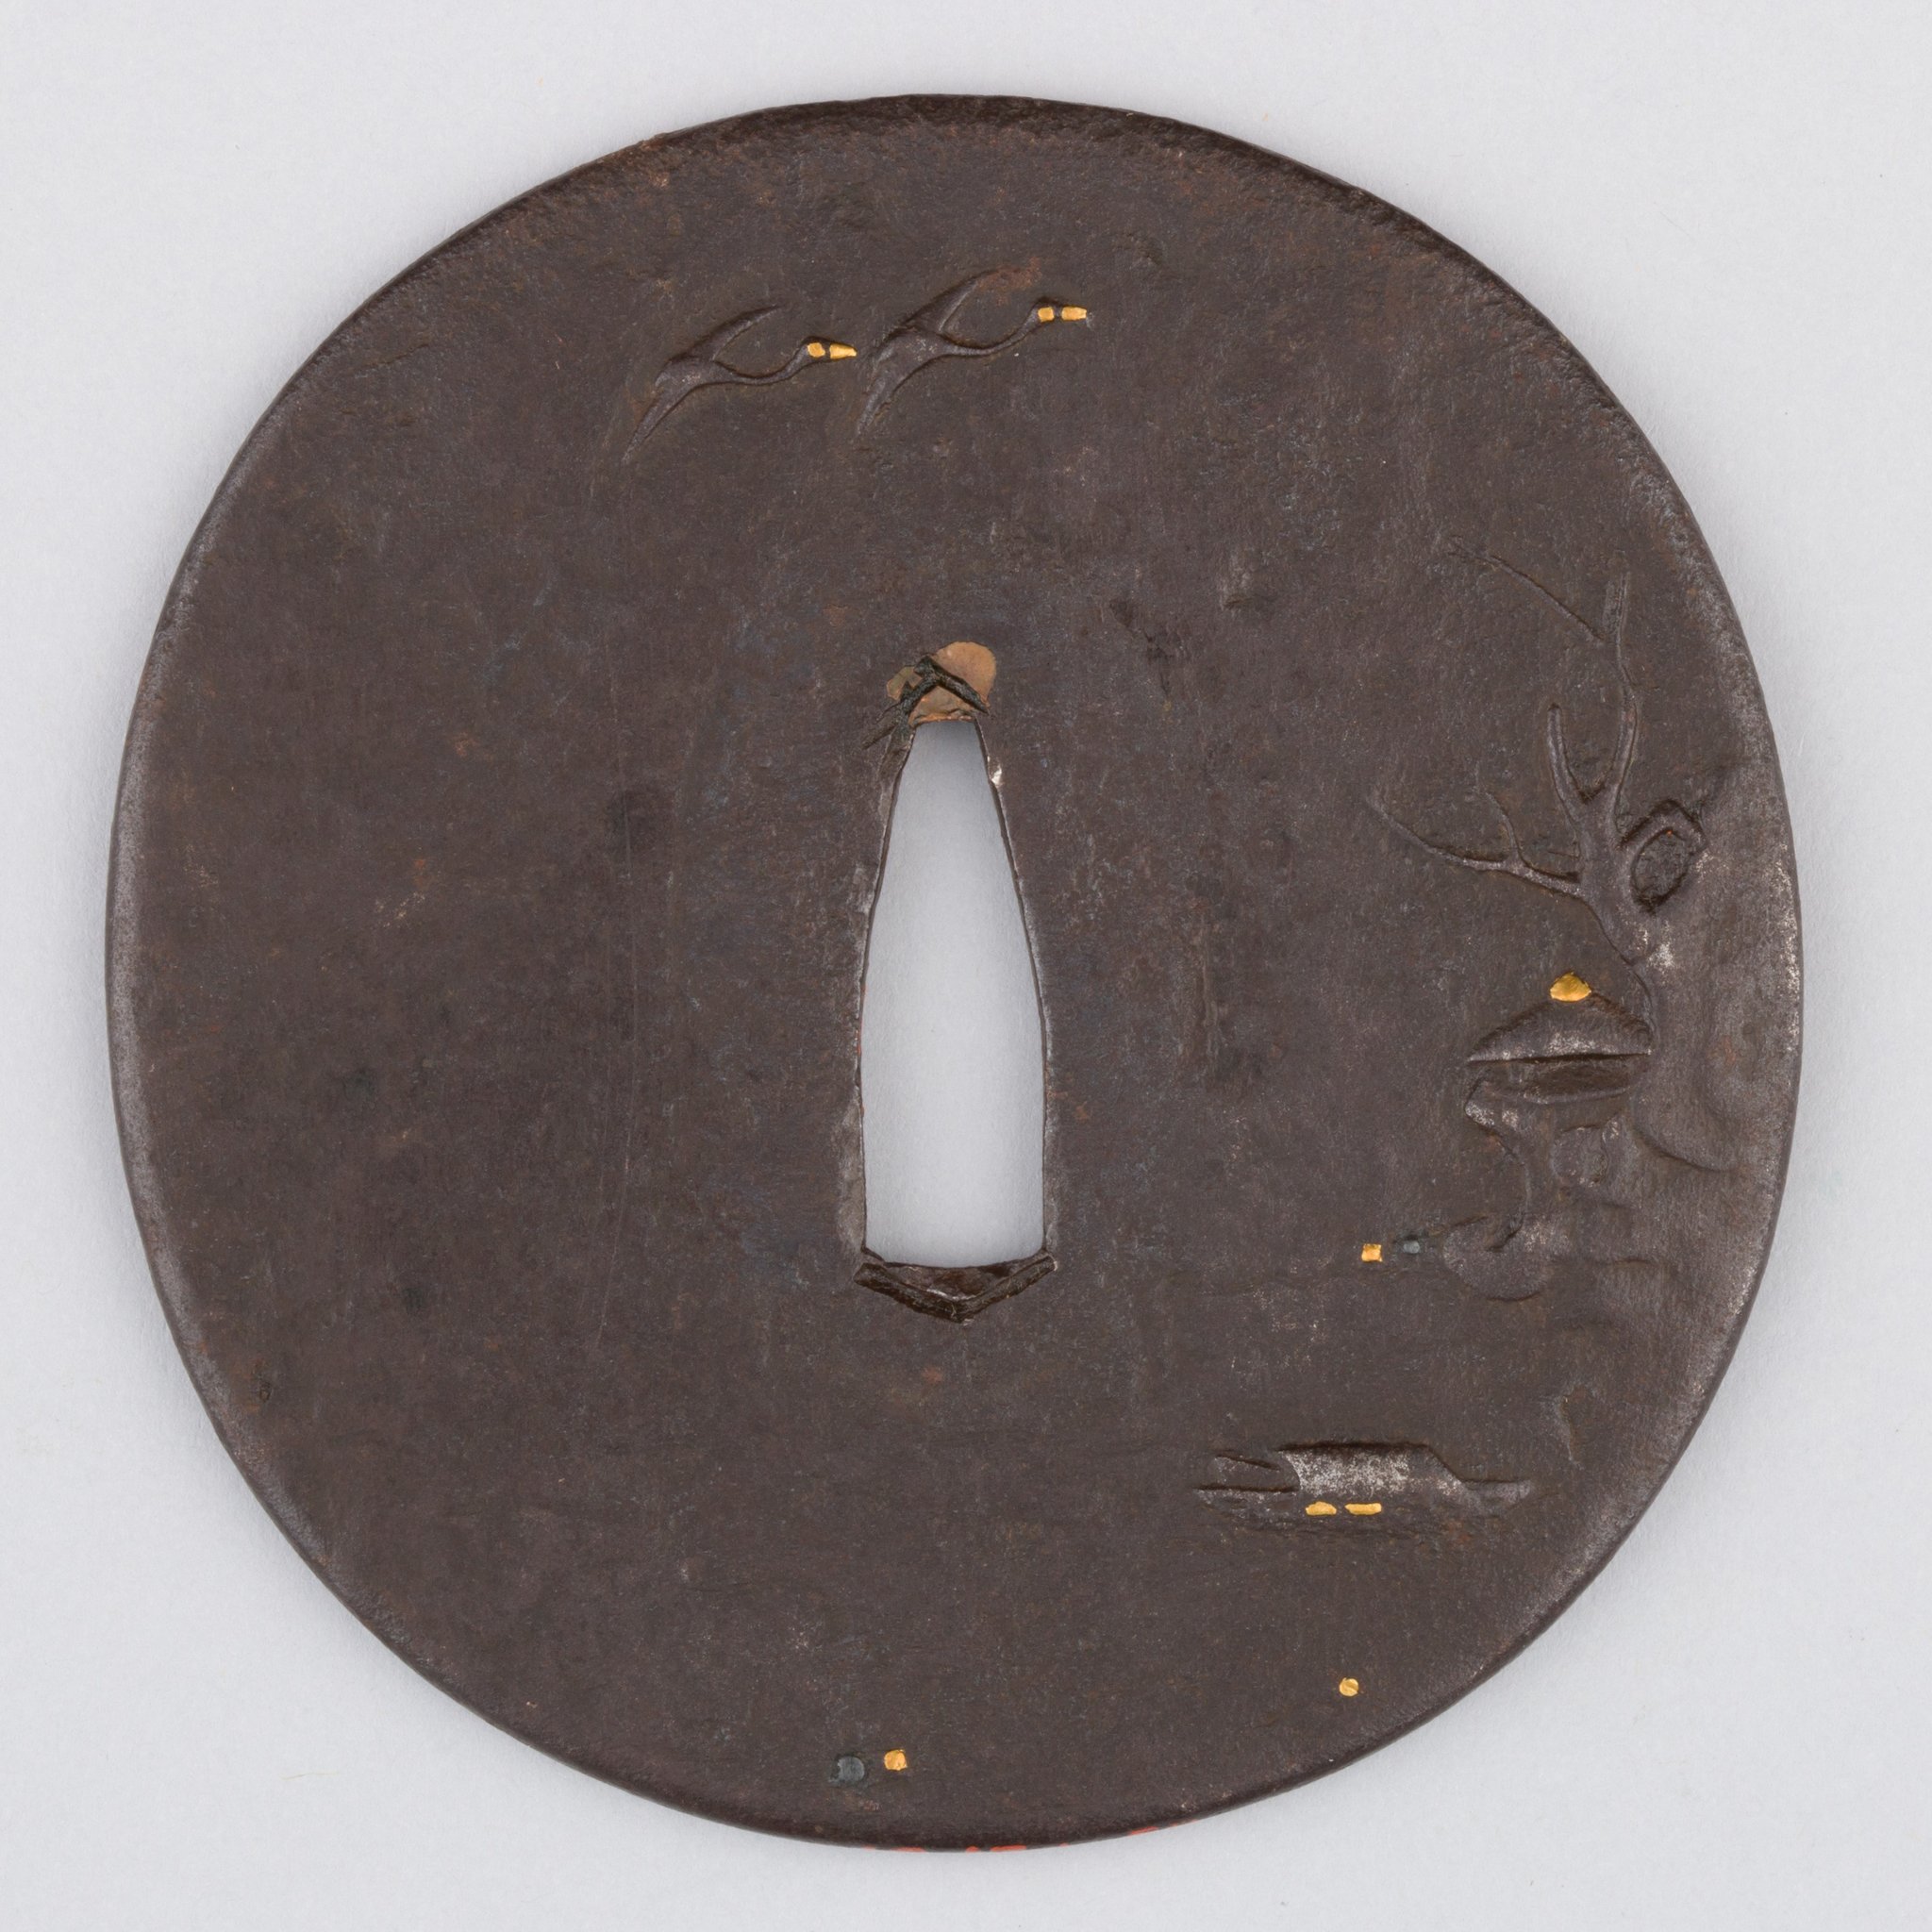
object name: sword guard tsuba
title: Sword Guard (Tsuba)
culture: japanese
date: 1615-1868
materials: copper, iron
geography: japan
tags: geese,boats